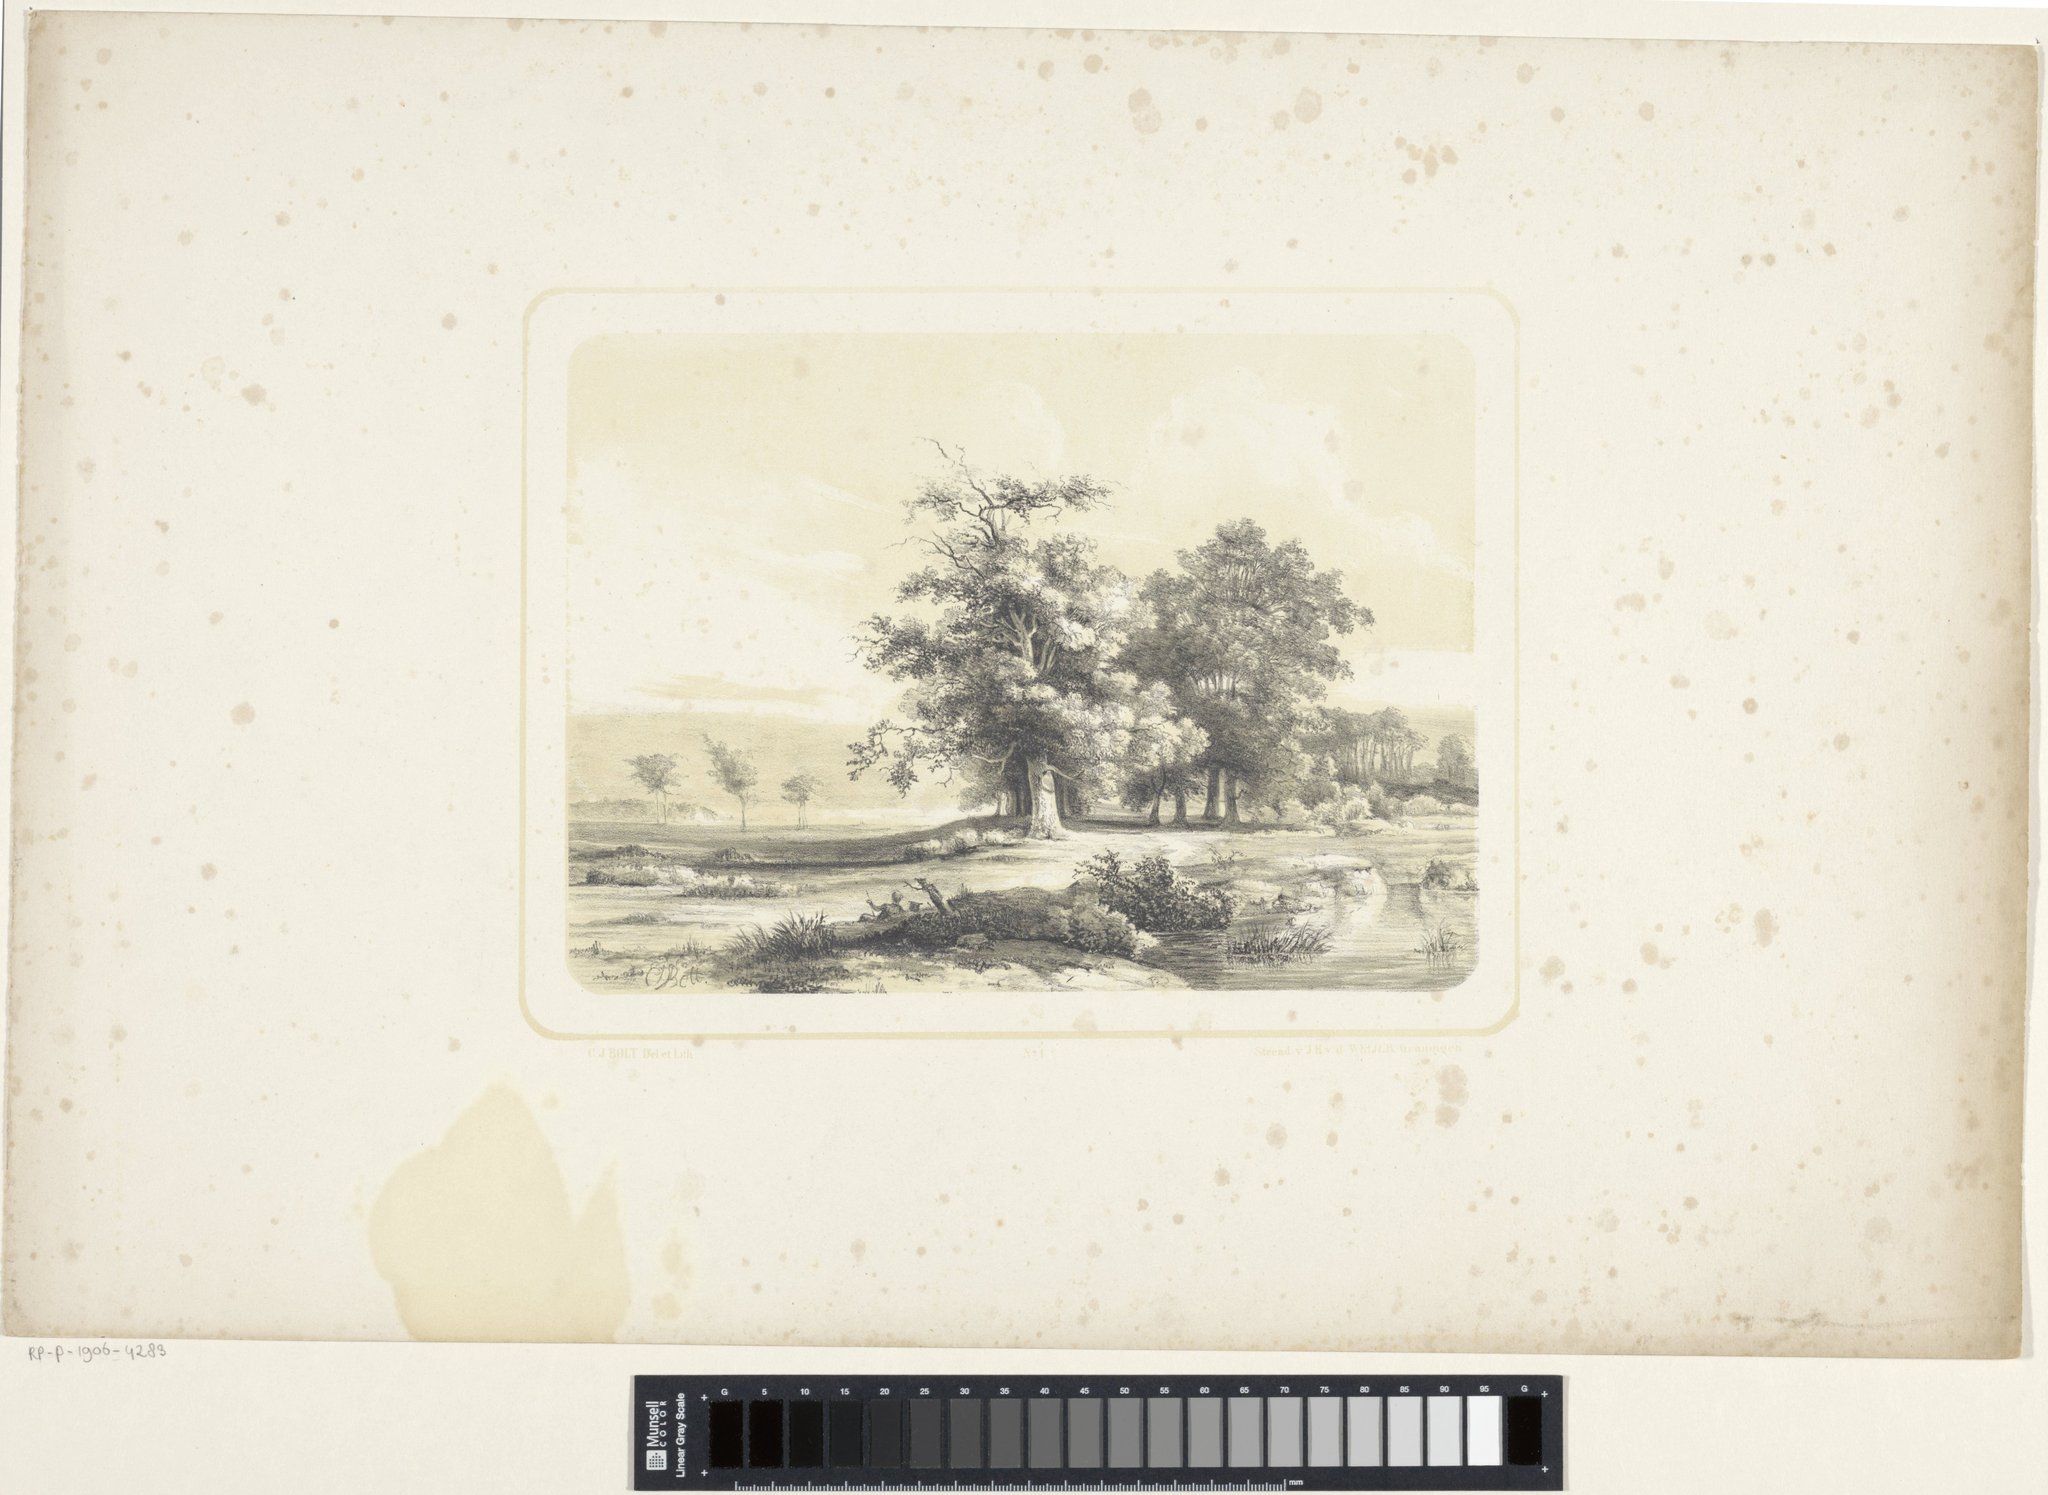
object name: print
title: Zes landschappen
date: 1833-1879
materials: paper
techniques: tone lithography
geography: netherlands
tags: landscapes in the temperate zone, resting - bb - out of doors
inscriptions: collector's mark: Lugt 2228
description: Links van het midden ligt een figuur op de grond. In zijn rechterhand heeft hij een wandelstok, zijn hoed heeft hij afgezet en naast zich neergelegd. In het midden enkele bomen en rechts water. Midden onder de afbeelding staat: no. 1.